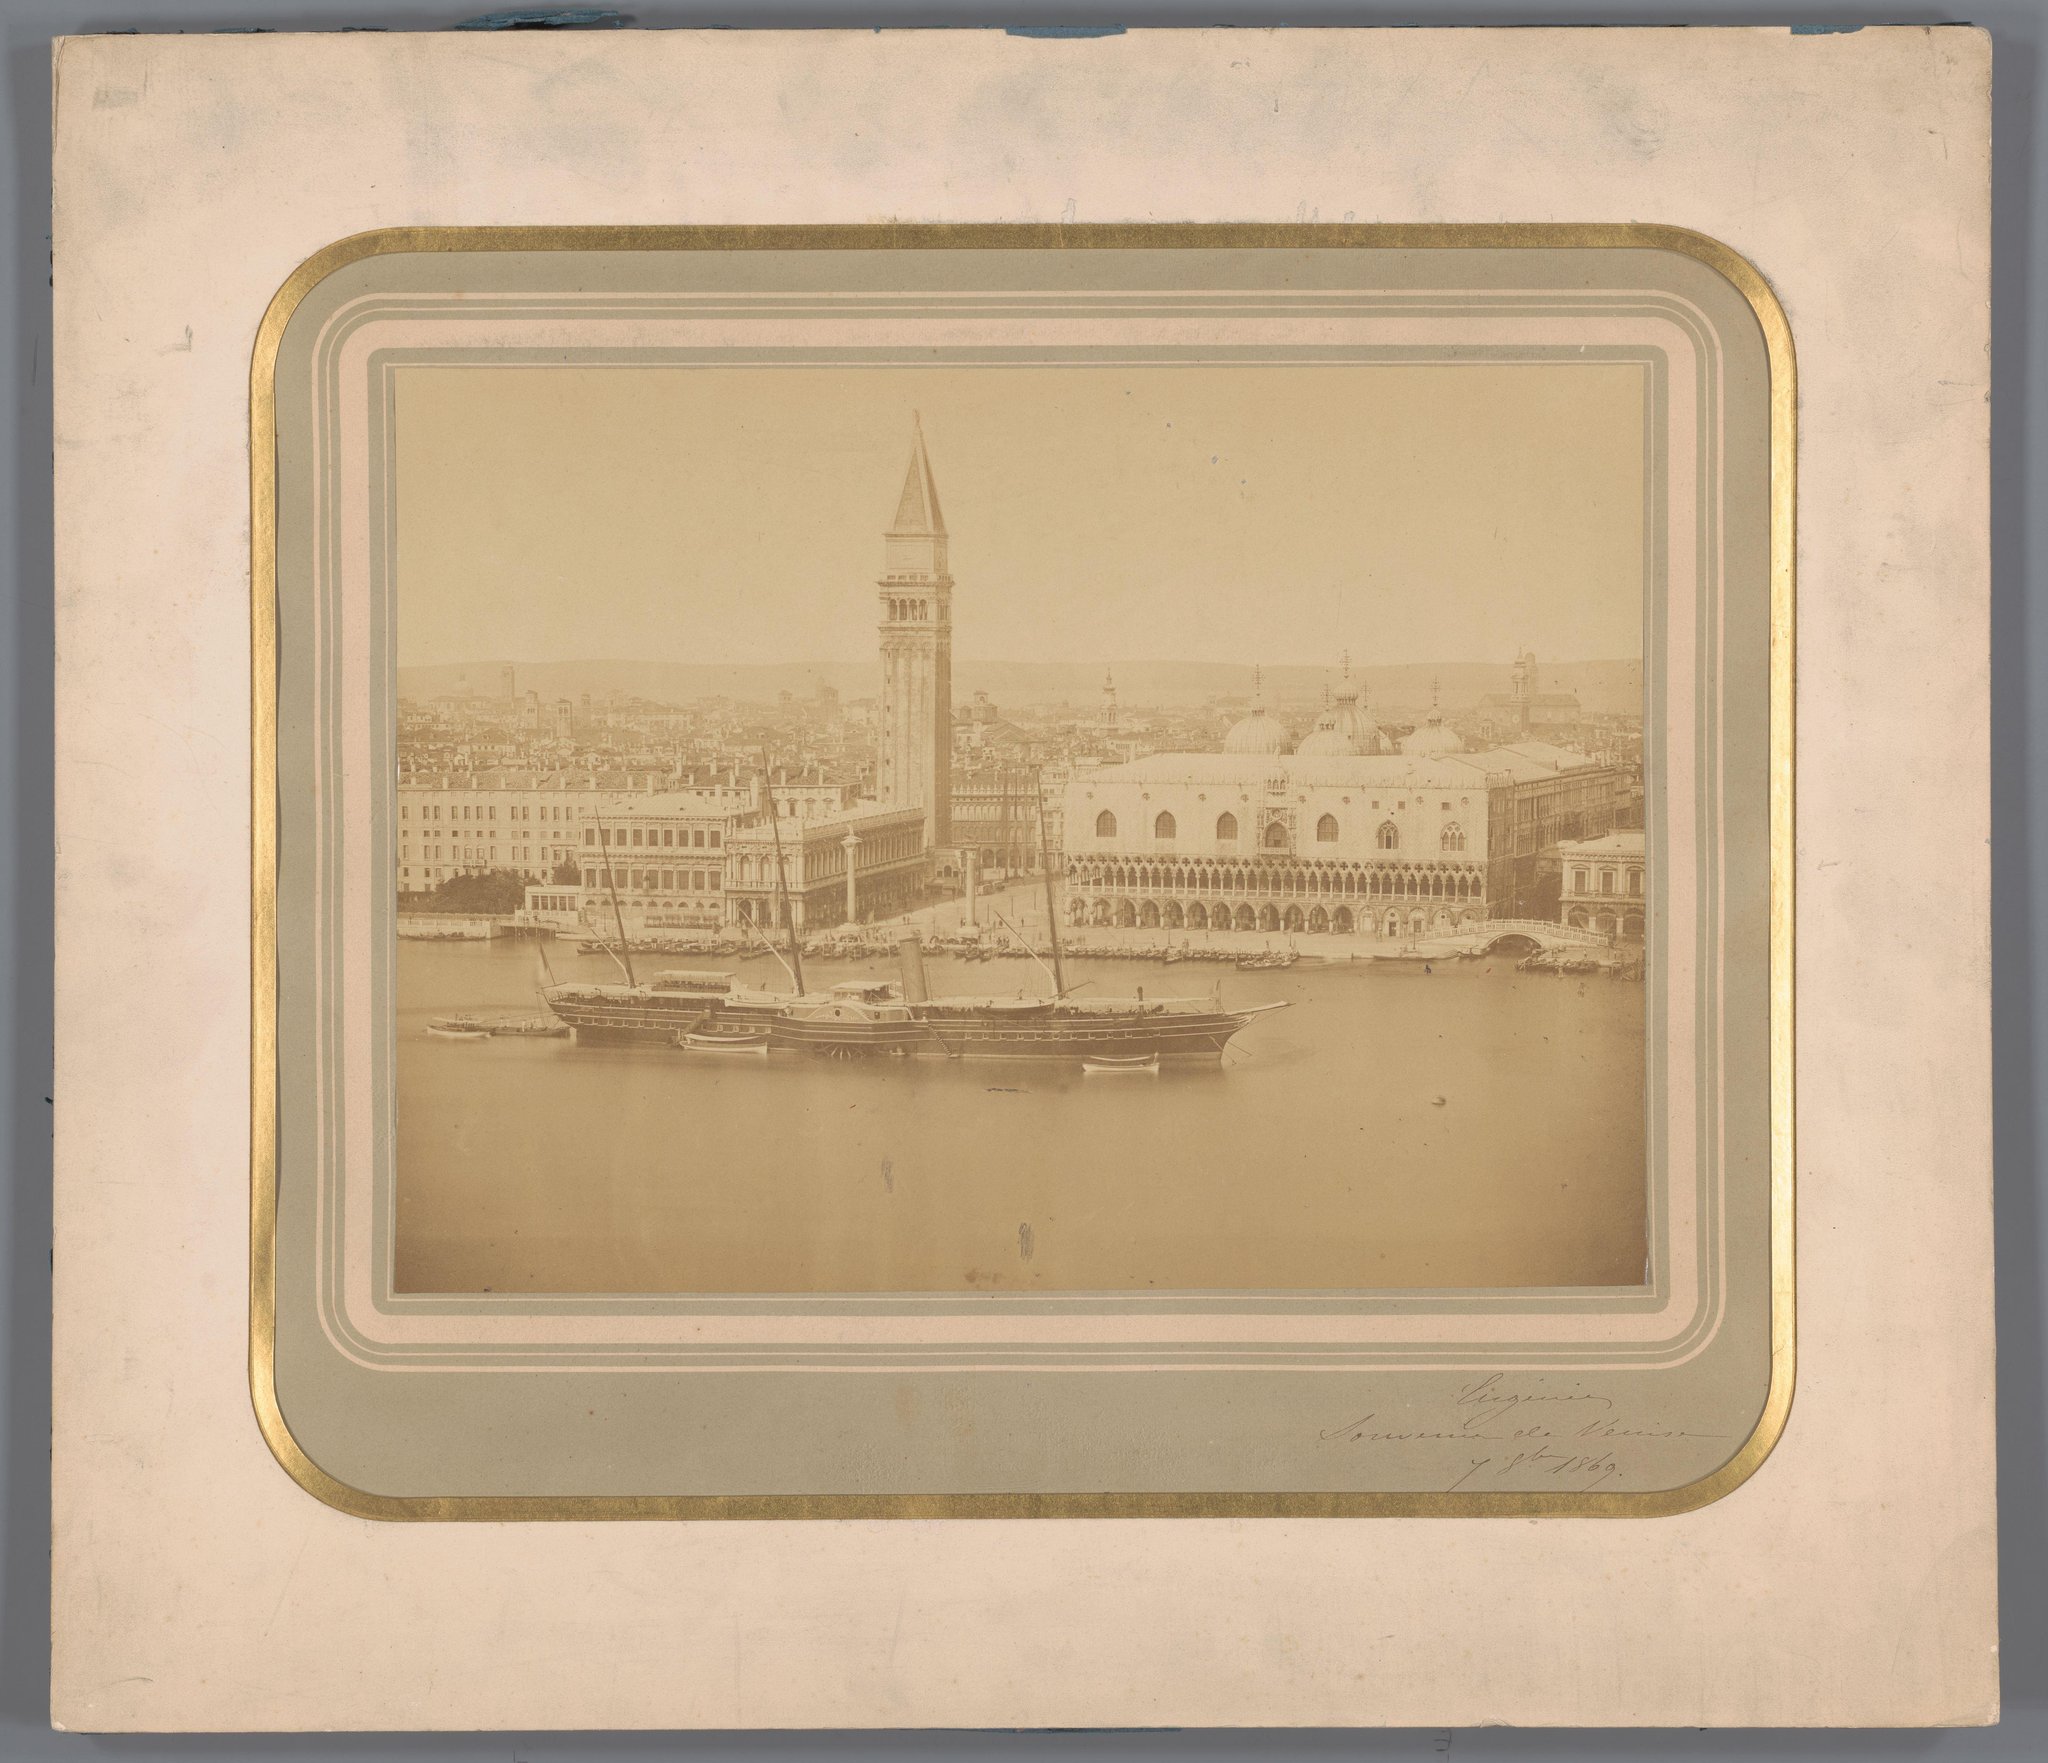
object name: photograph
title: Venetië vanuit de lucht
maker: carlo ponti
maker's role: fotograaf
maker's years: 1820-1893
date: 1869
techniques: albumen print